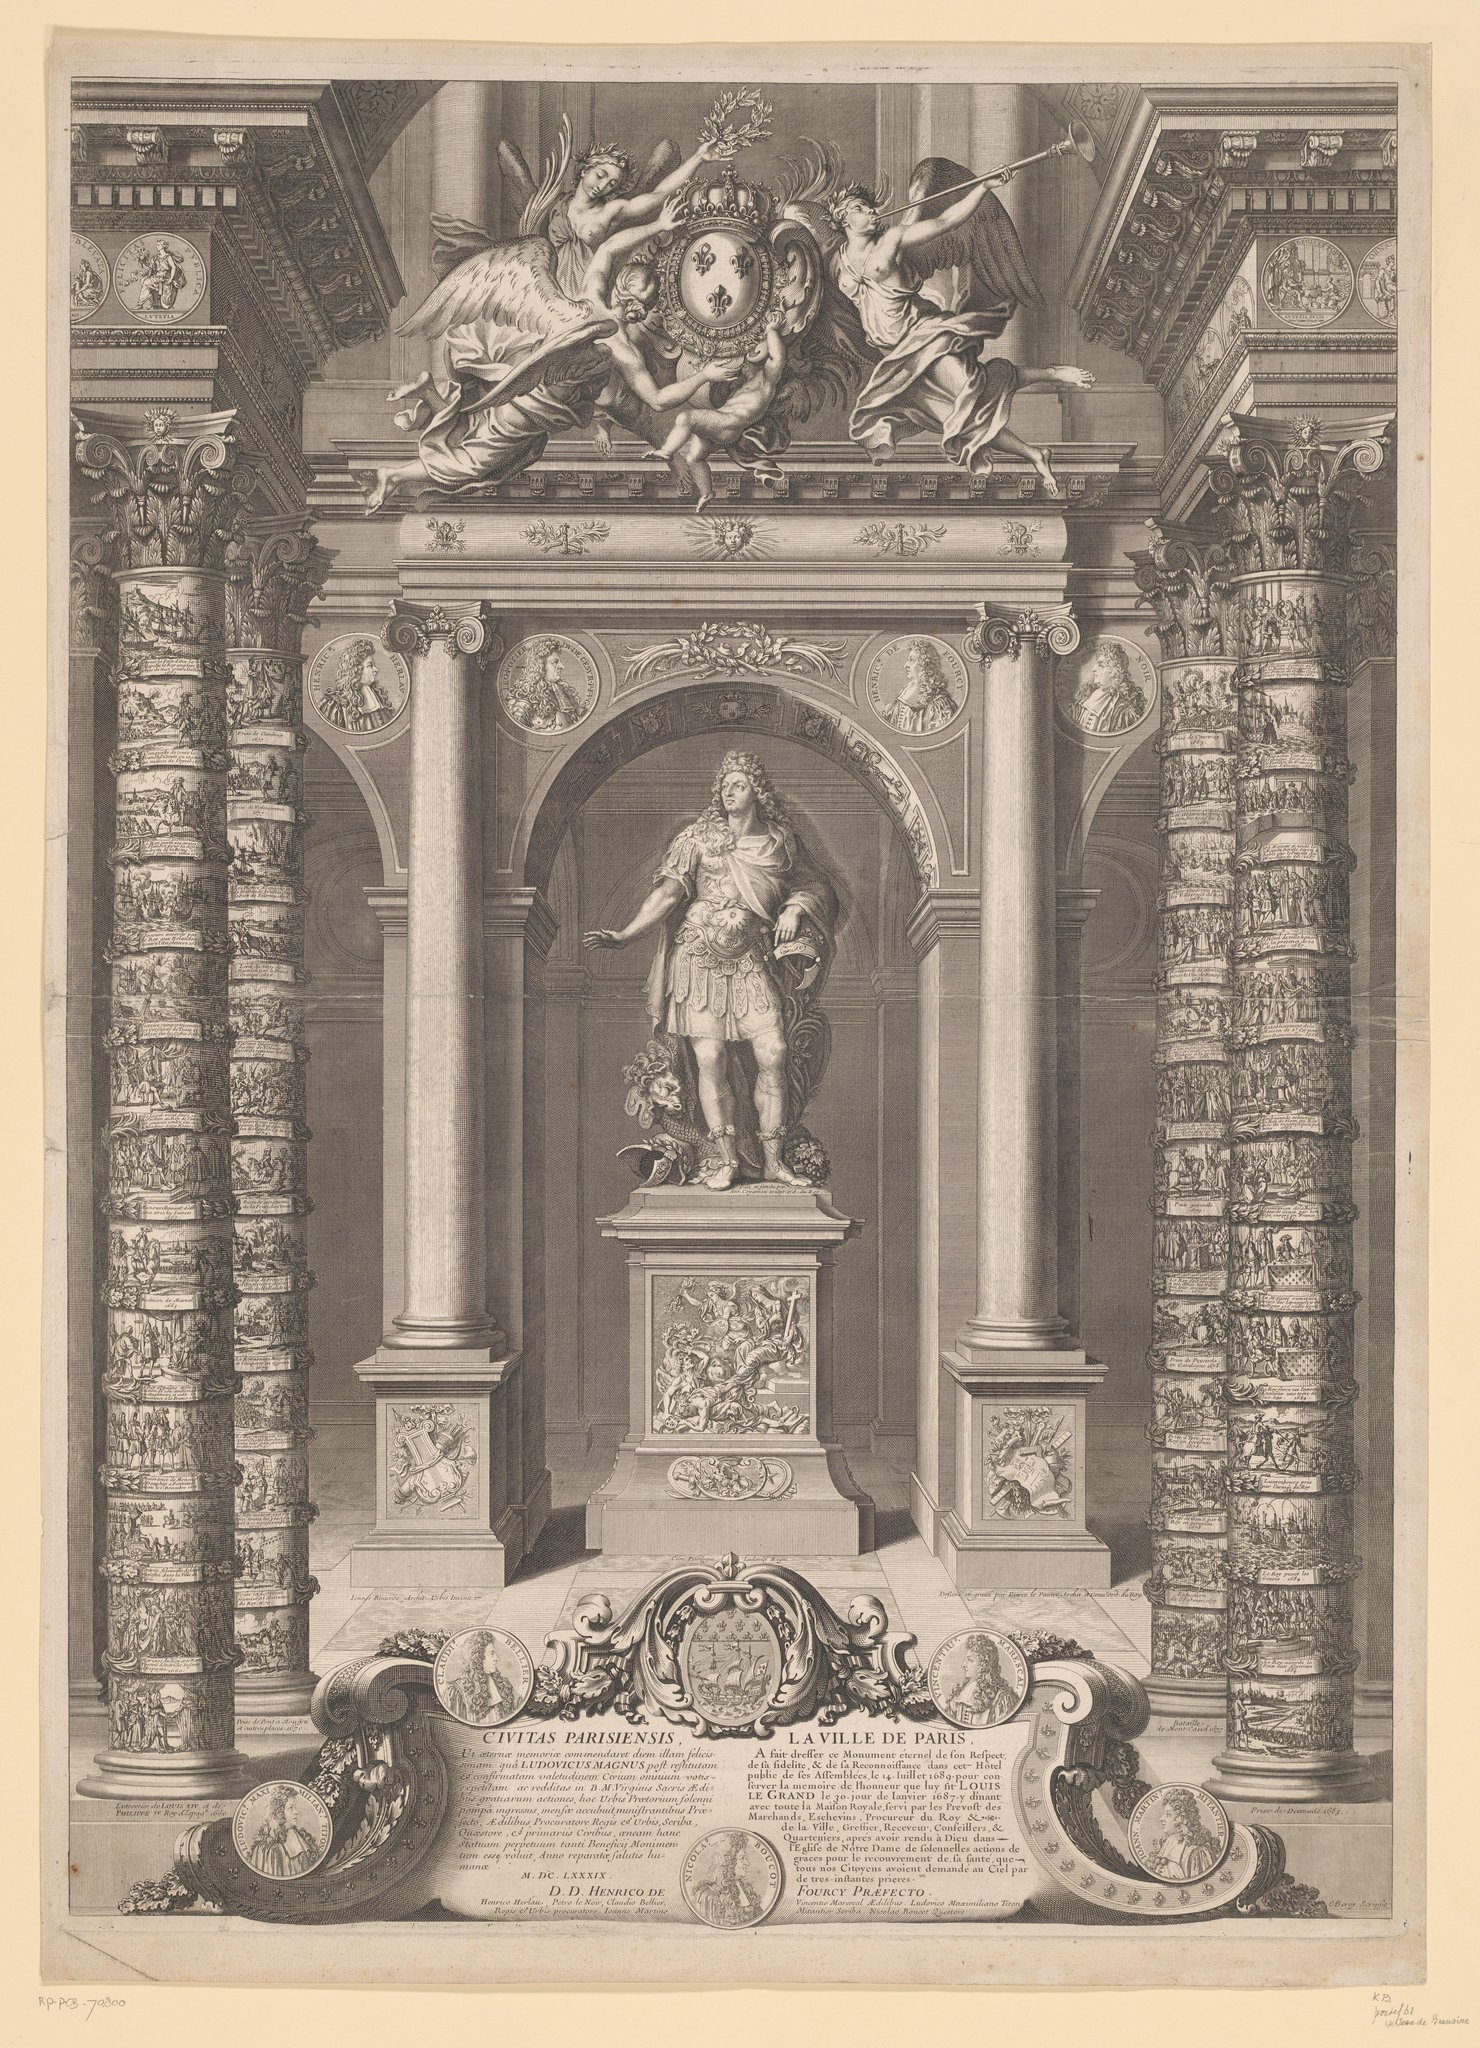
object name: print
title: Monument voor Lodewijk XIV geschonken door de stad Parijs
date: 1689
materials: paper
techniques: engraving, etching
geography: paris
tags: lodewijk xiv (koning van frankrijk), monument, statue, paris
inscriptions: collector's mark: Lugt 240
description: Met onderschrift in het Latijn en Frans, verdeeld in twee kolommen.